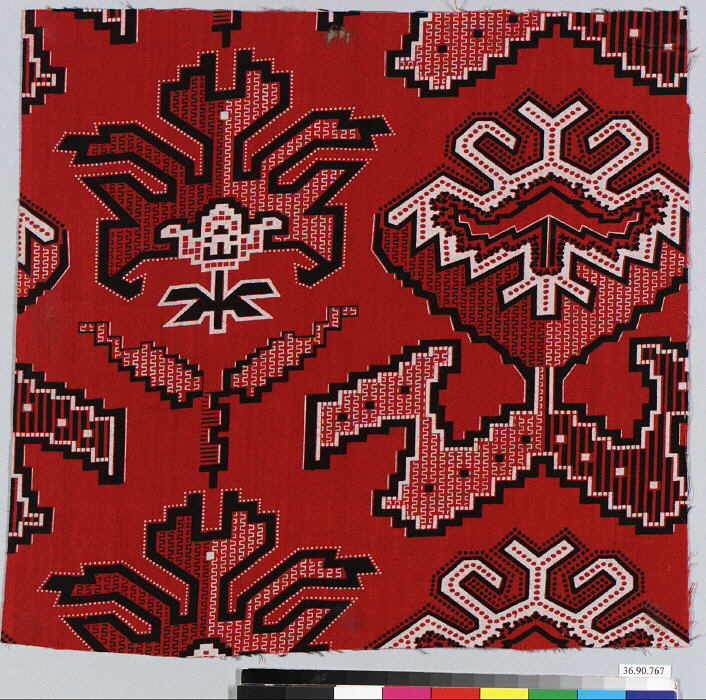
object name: piece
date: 1867-1900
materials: cotton